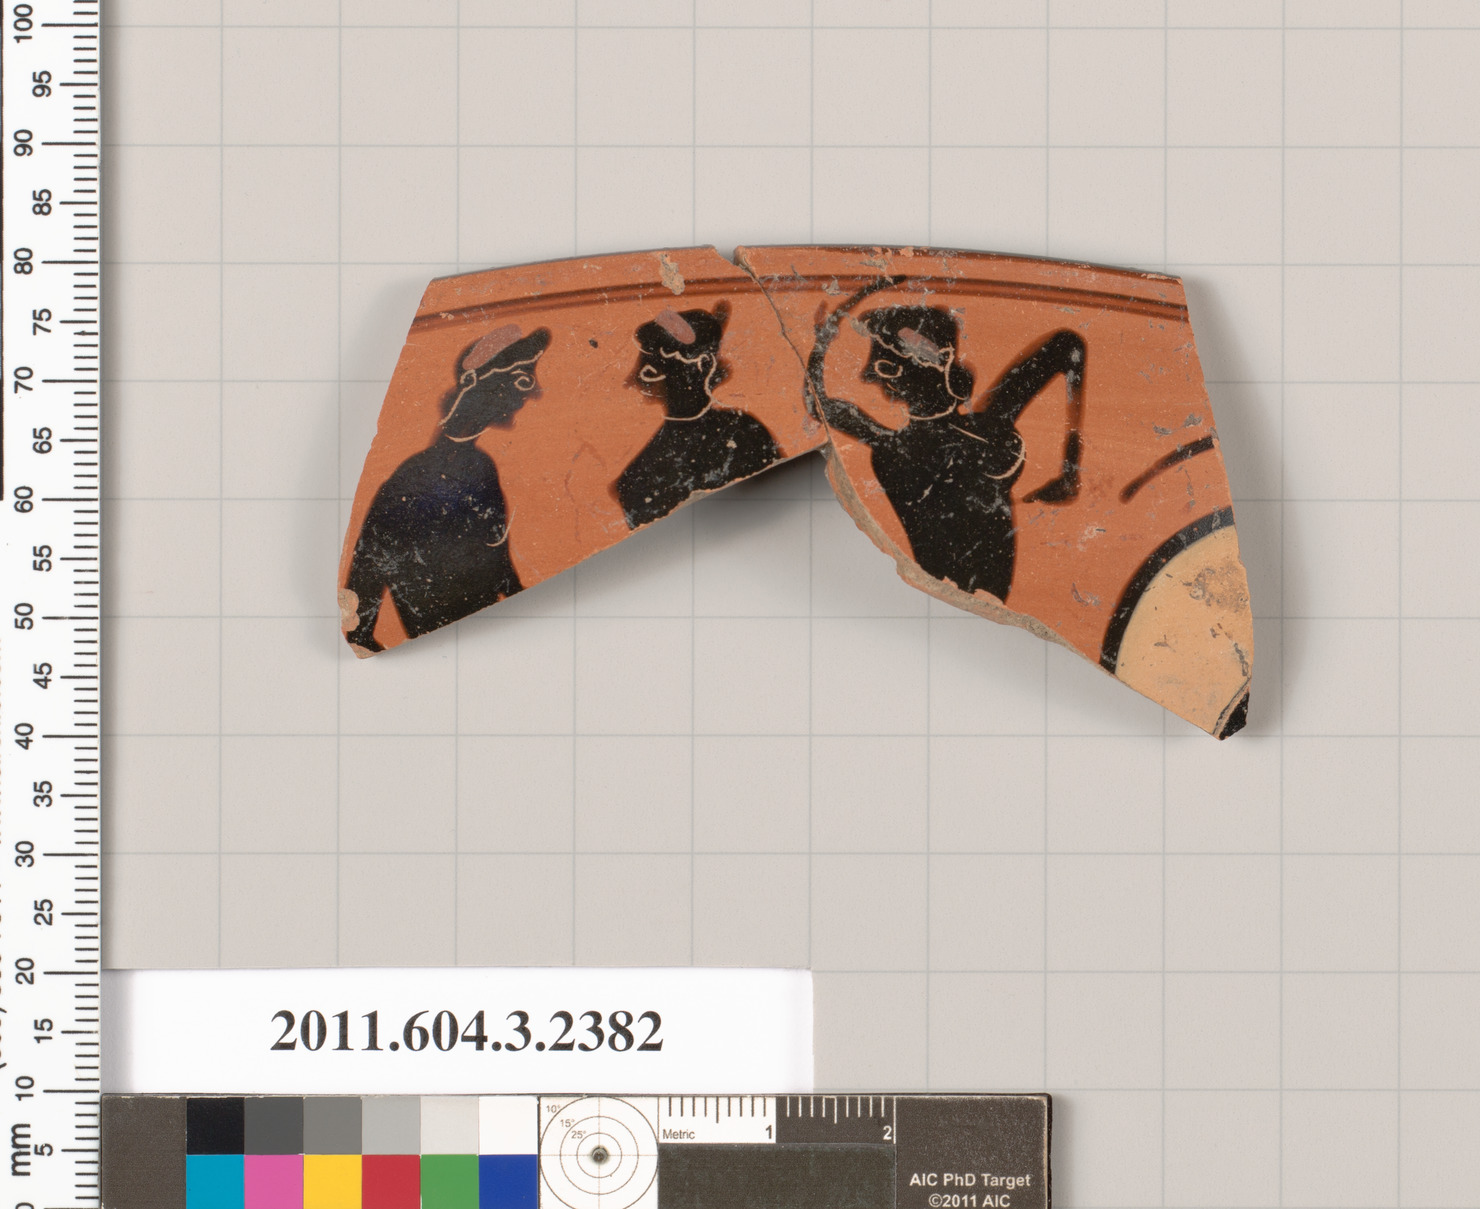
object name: kylix fragment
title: Terracotta rim fragment of a kylix: eye-cup (drinking cup)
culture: greek, attic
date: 534-501 BCE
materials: terracotta